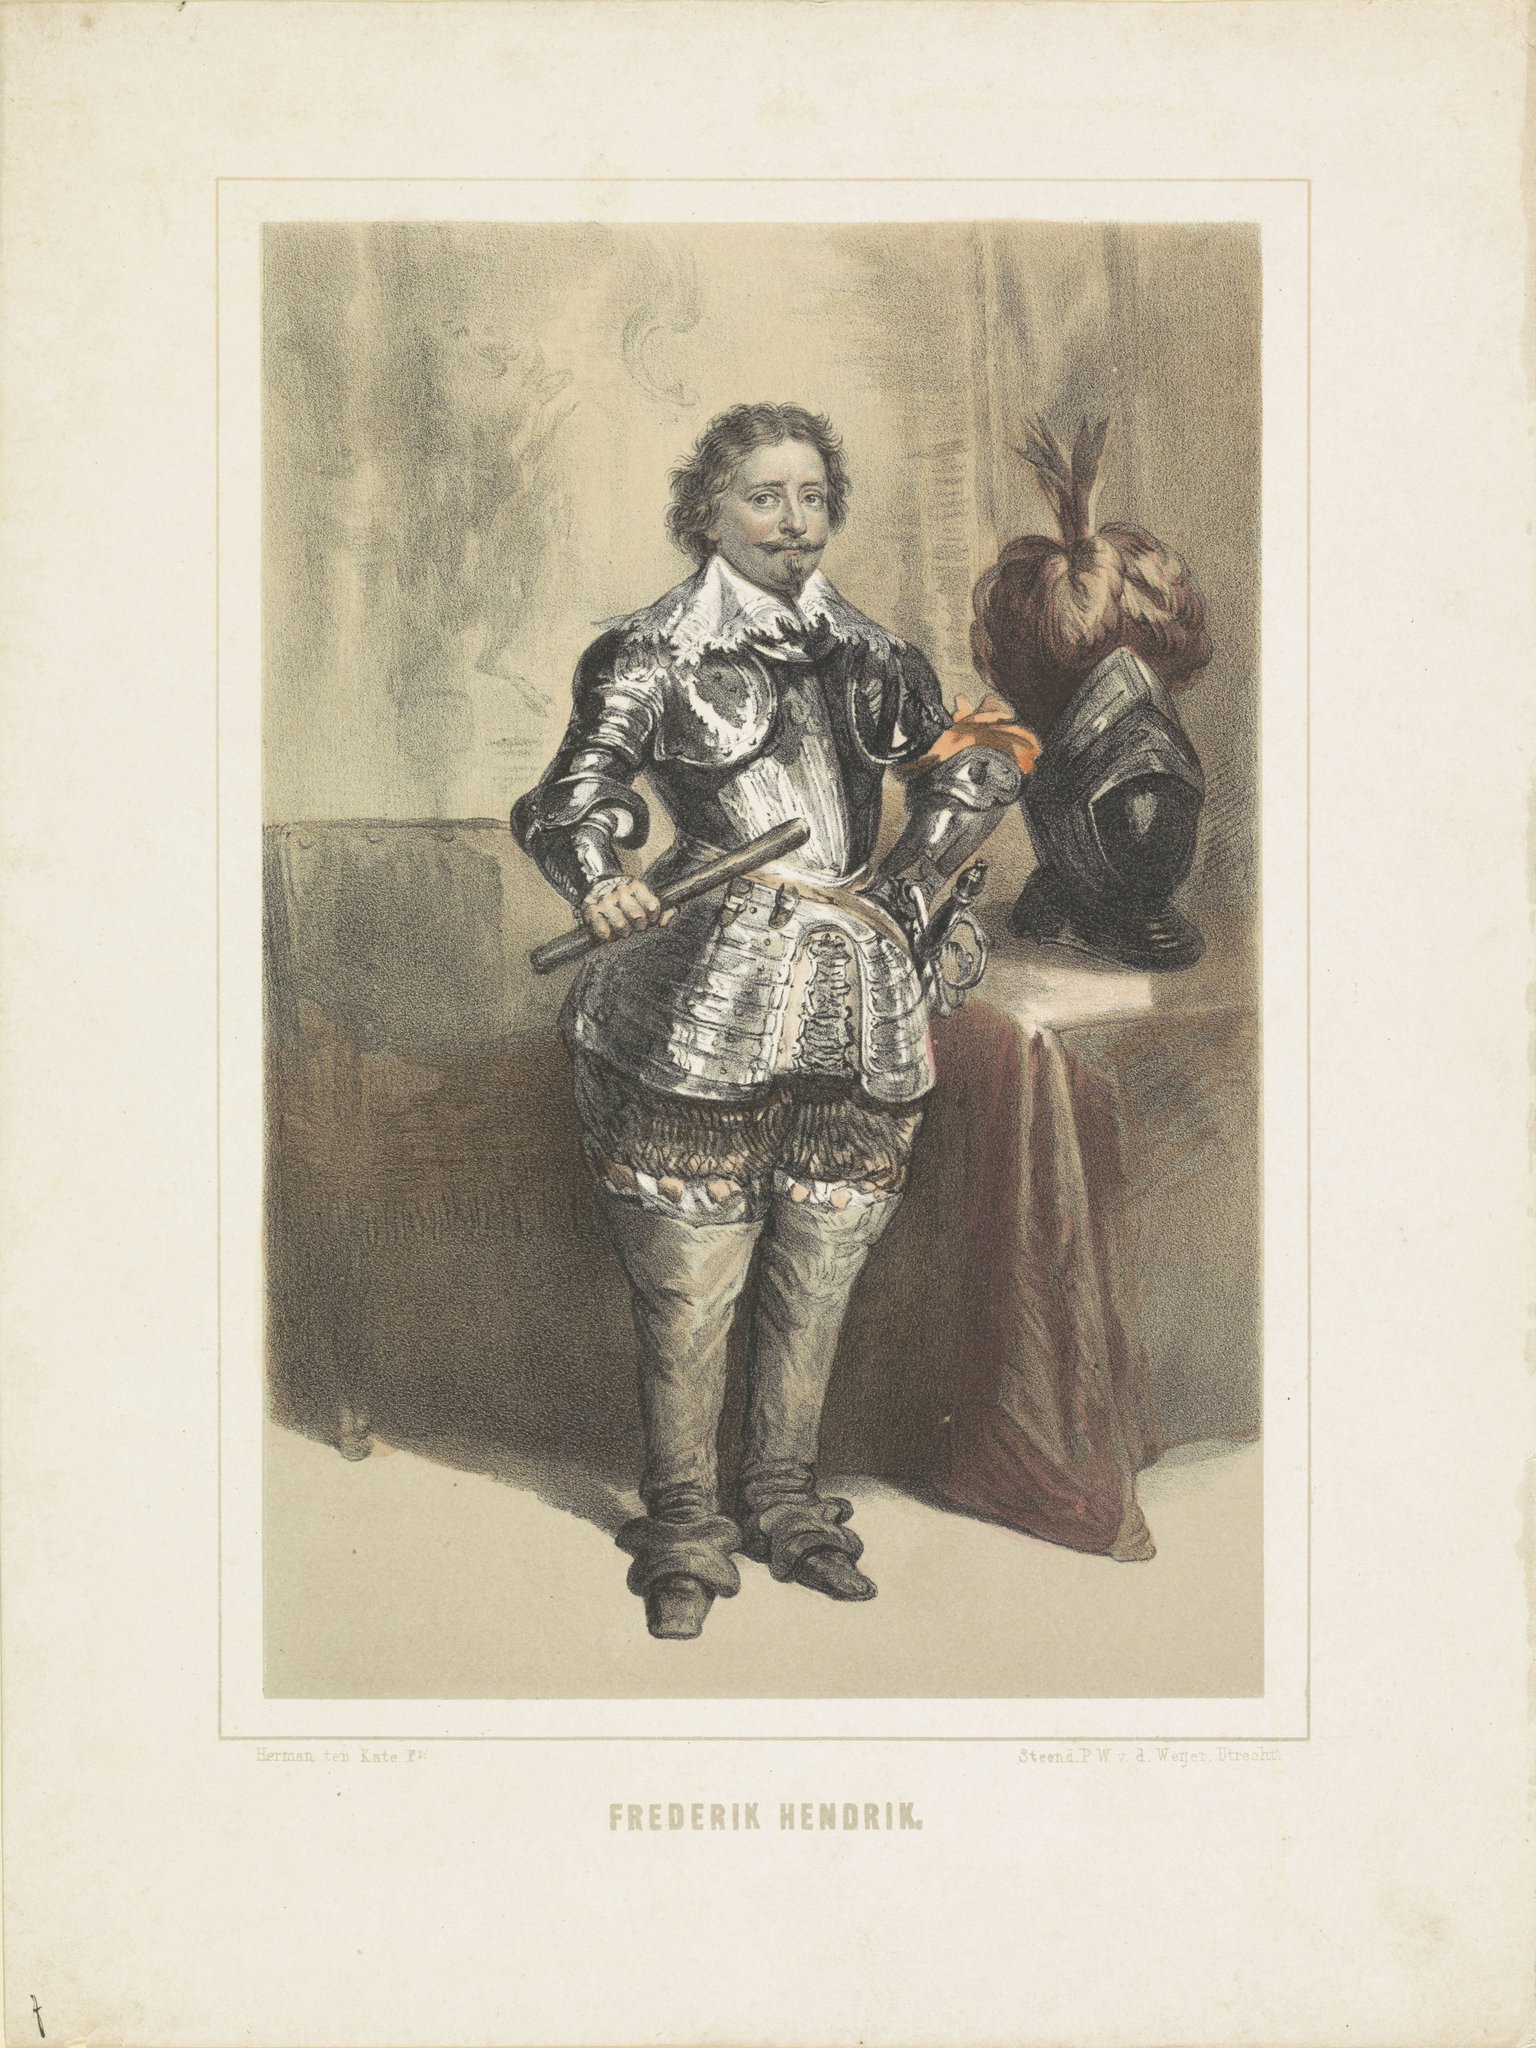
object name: print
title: Portret van Frederik Hendrik, prins van Oranje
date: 1831-1880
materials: paper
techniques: lithograph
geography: utrecht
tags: delft, the hague, frederick henry (prince of orange)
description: Portret van Frederik Hendrik. Hij staat in een vertrek naast een tafel, daarop de helm van zijn harnas. Hij houdt een commandostaf in de hand. In de ondermarge zijn naam.